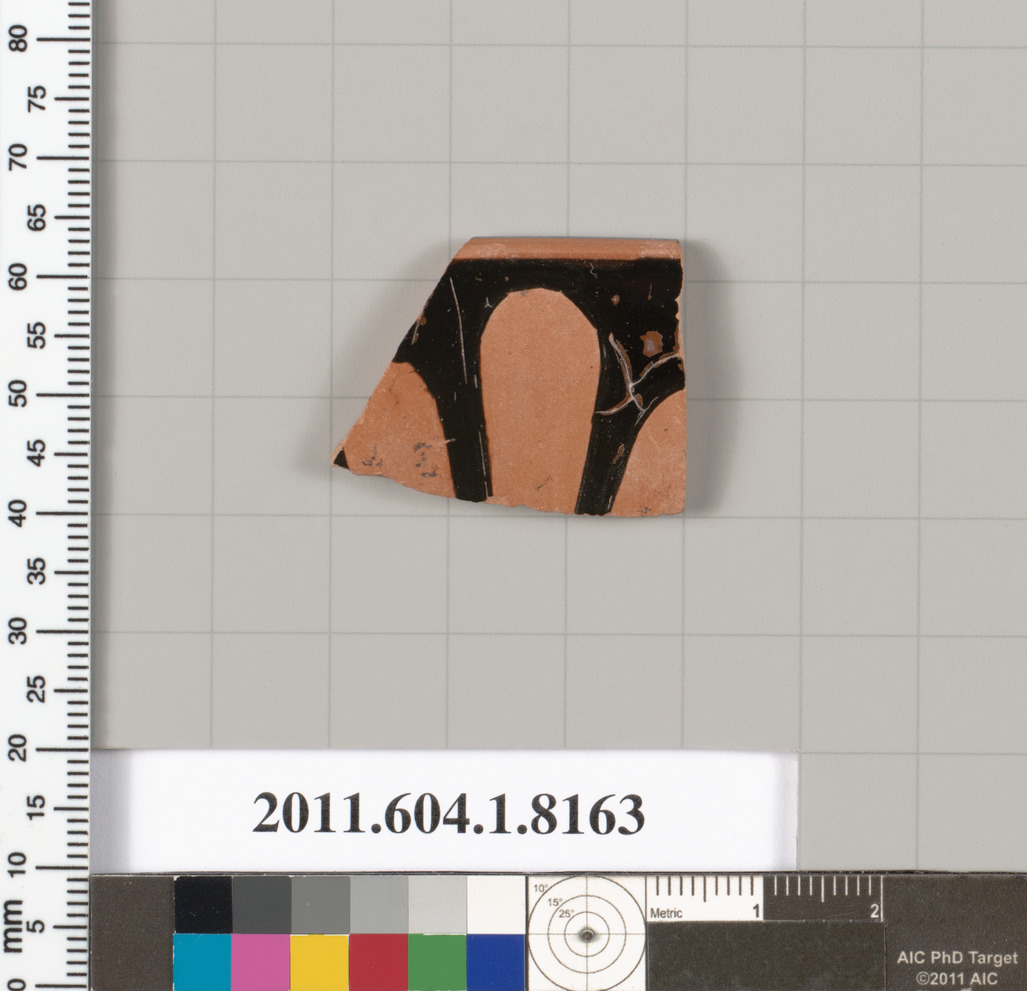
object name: kylix fragment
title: Terracotta rim fragment of a kylix (drinking cup)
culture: greek, attic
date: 520-510 BCE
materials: terracotta